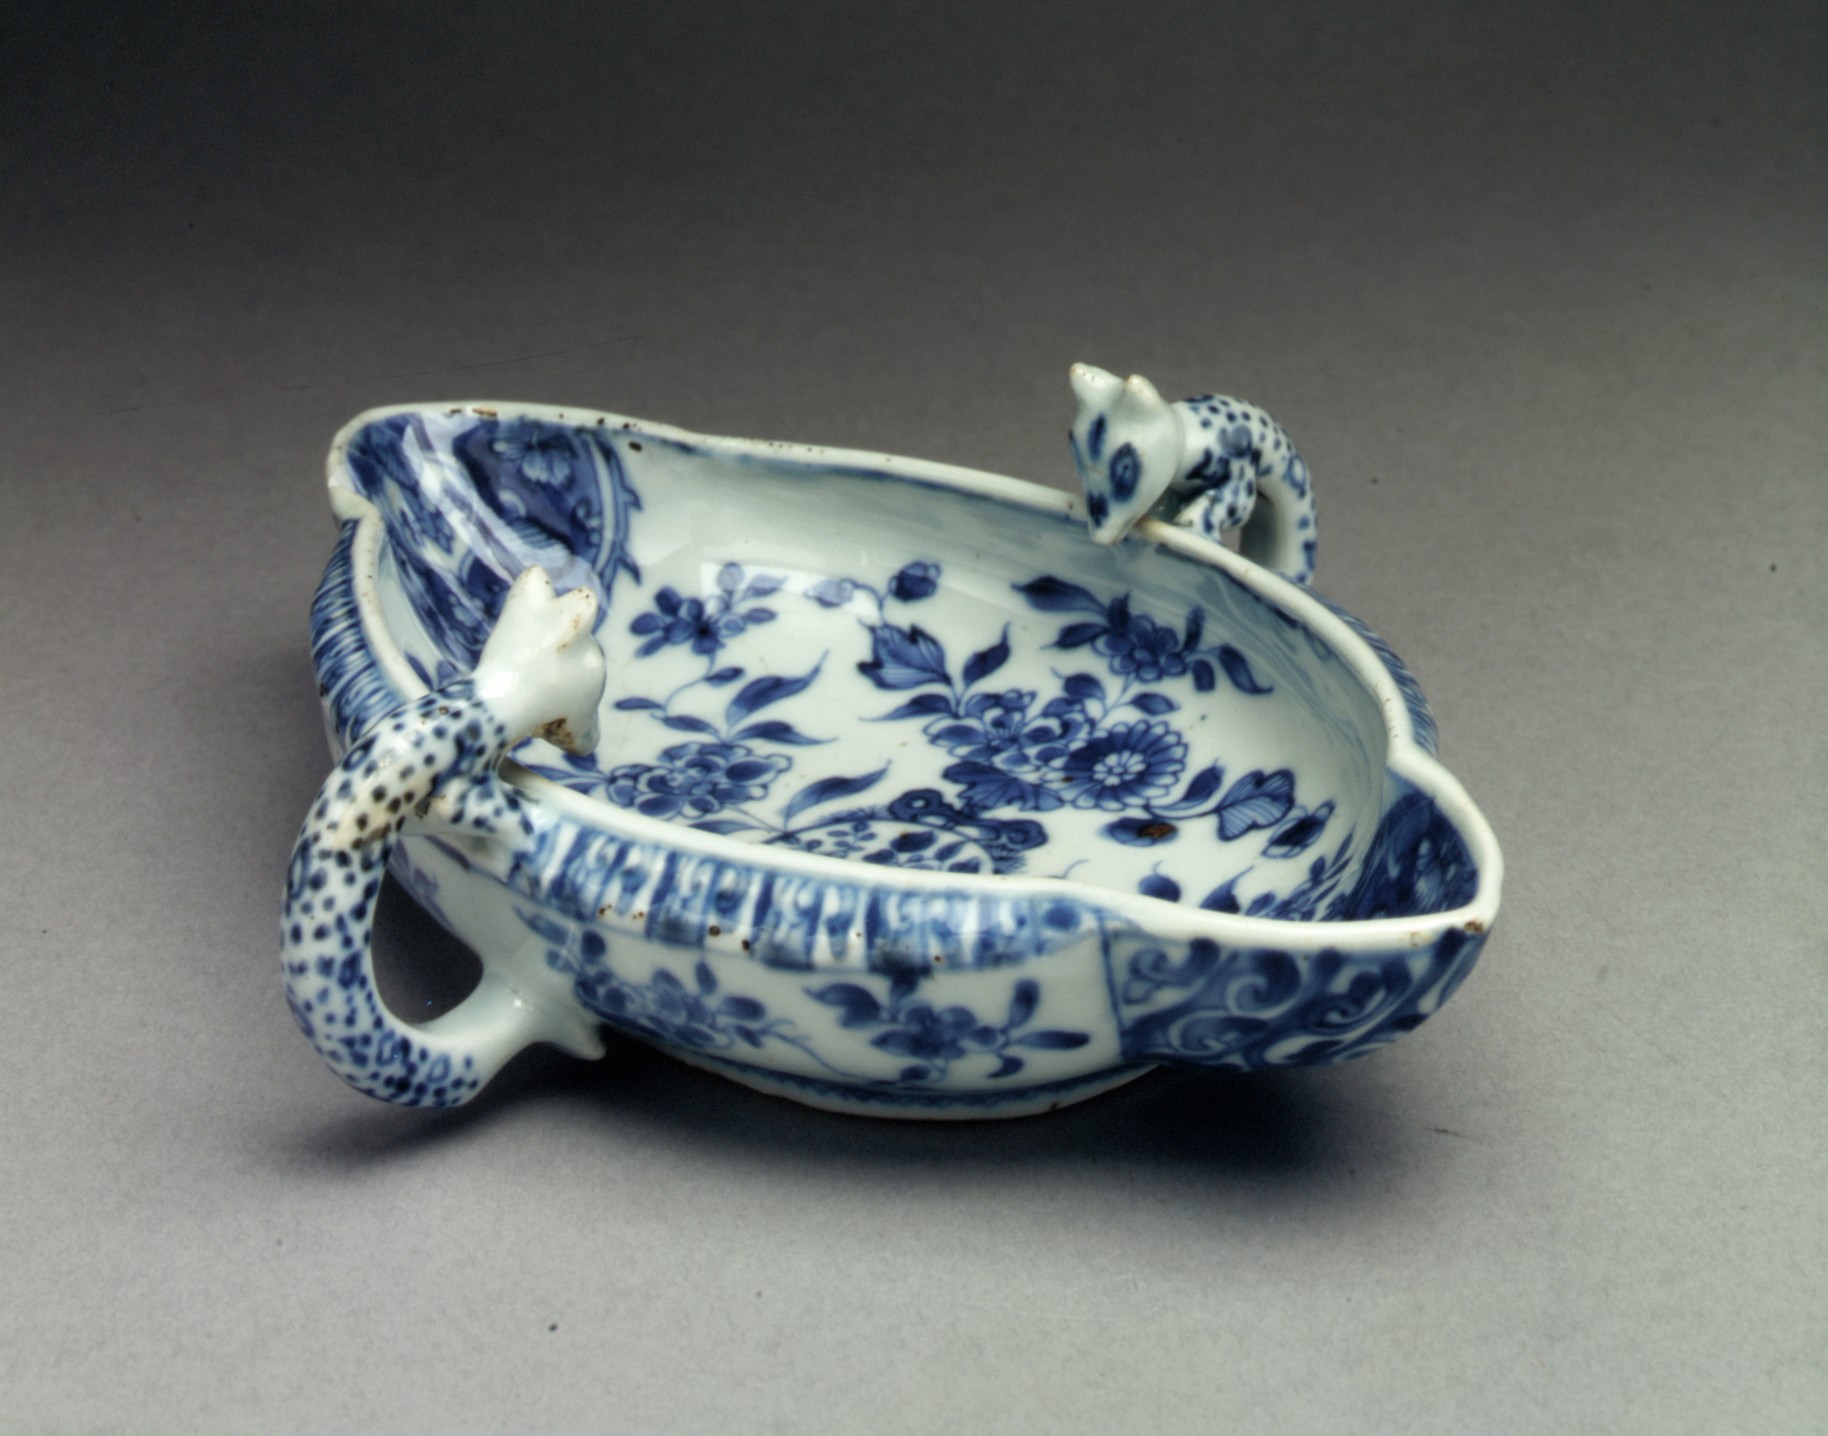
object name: sauceboat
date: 1760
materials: hard paste porcelain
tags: animals,flowers